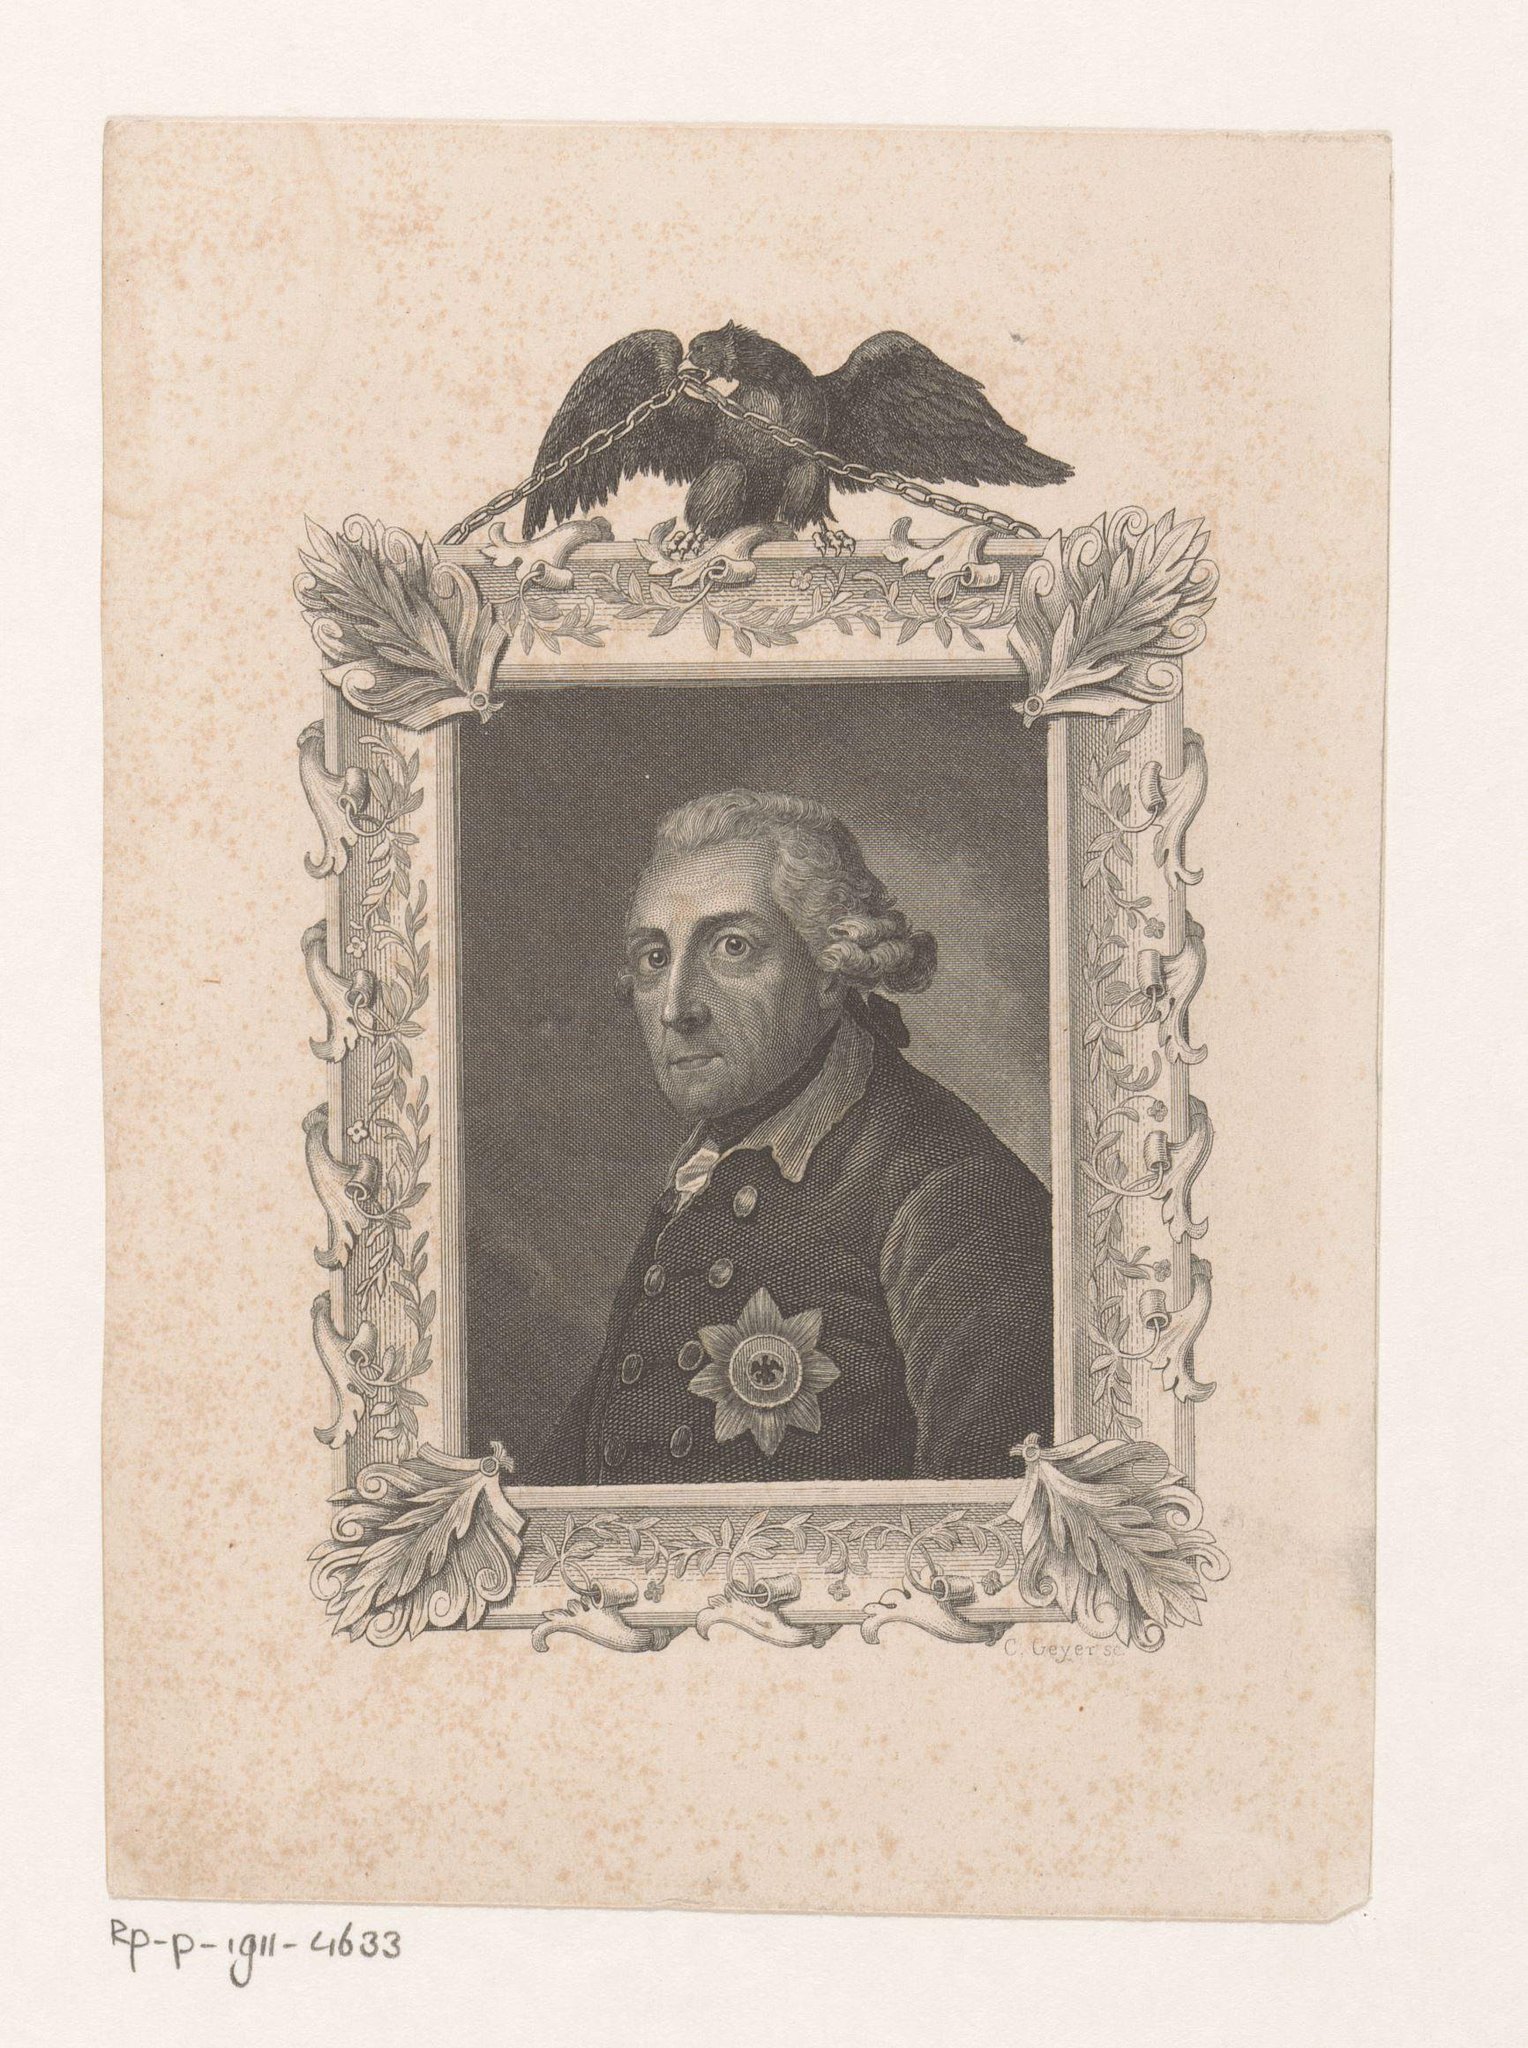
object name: print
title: Portret van Frederik de Grote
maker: conrad geyer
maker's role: print maker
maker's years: 1816-1893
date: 1826-1893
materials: paper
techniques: engraving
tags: berlin, frederick ii (king of prussia), predatory birds: eagle, knighthood order (with name) - insignia of a knighthood order, e.g.: badge, chain (with name of order), historical persons, emperor, frame of painting, etc.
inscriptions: collector's mark: Lugt 2228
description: Prent gebruikt voor: Goehring, Carl. Deutschlands Schlachtfelder, oder Geschichte sämmtlicher großen Kämpfe der Deutschen von Hermann, dem Cherusker, bis auf unsere Zeit. Leipzig: Teubner, 1848, dl. 3.